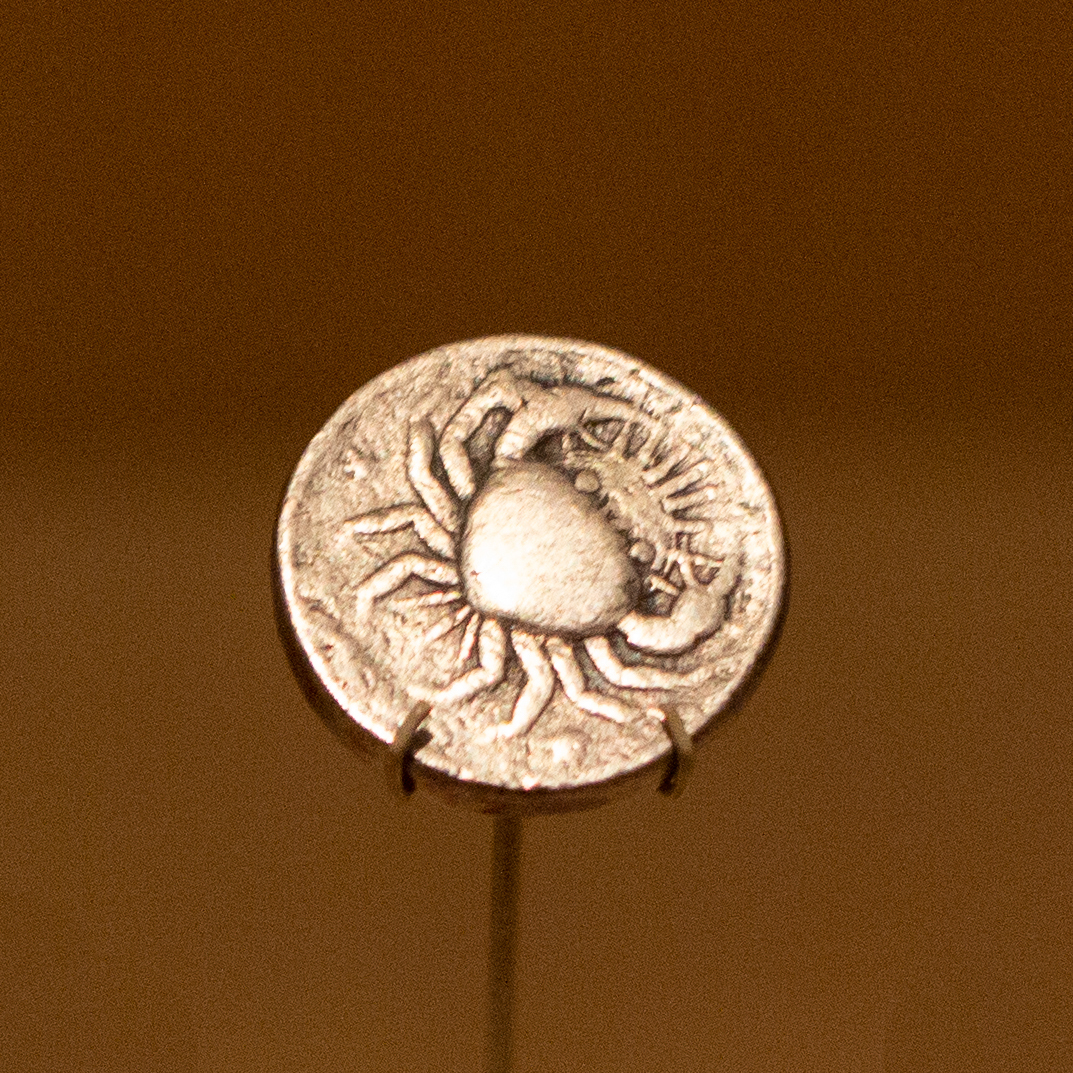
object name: coin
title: Coin with Sign of Cancer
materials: silver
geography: india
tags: crabs,zodiac